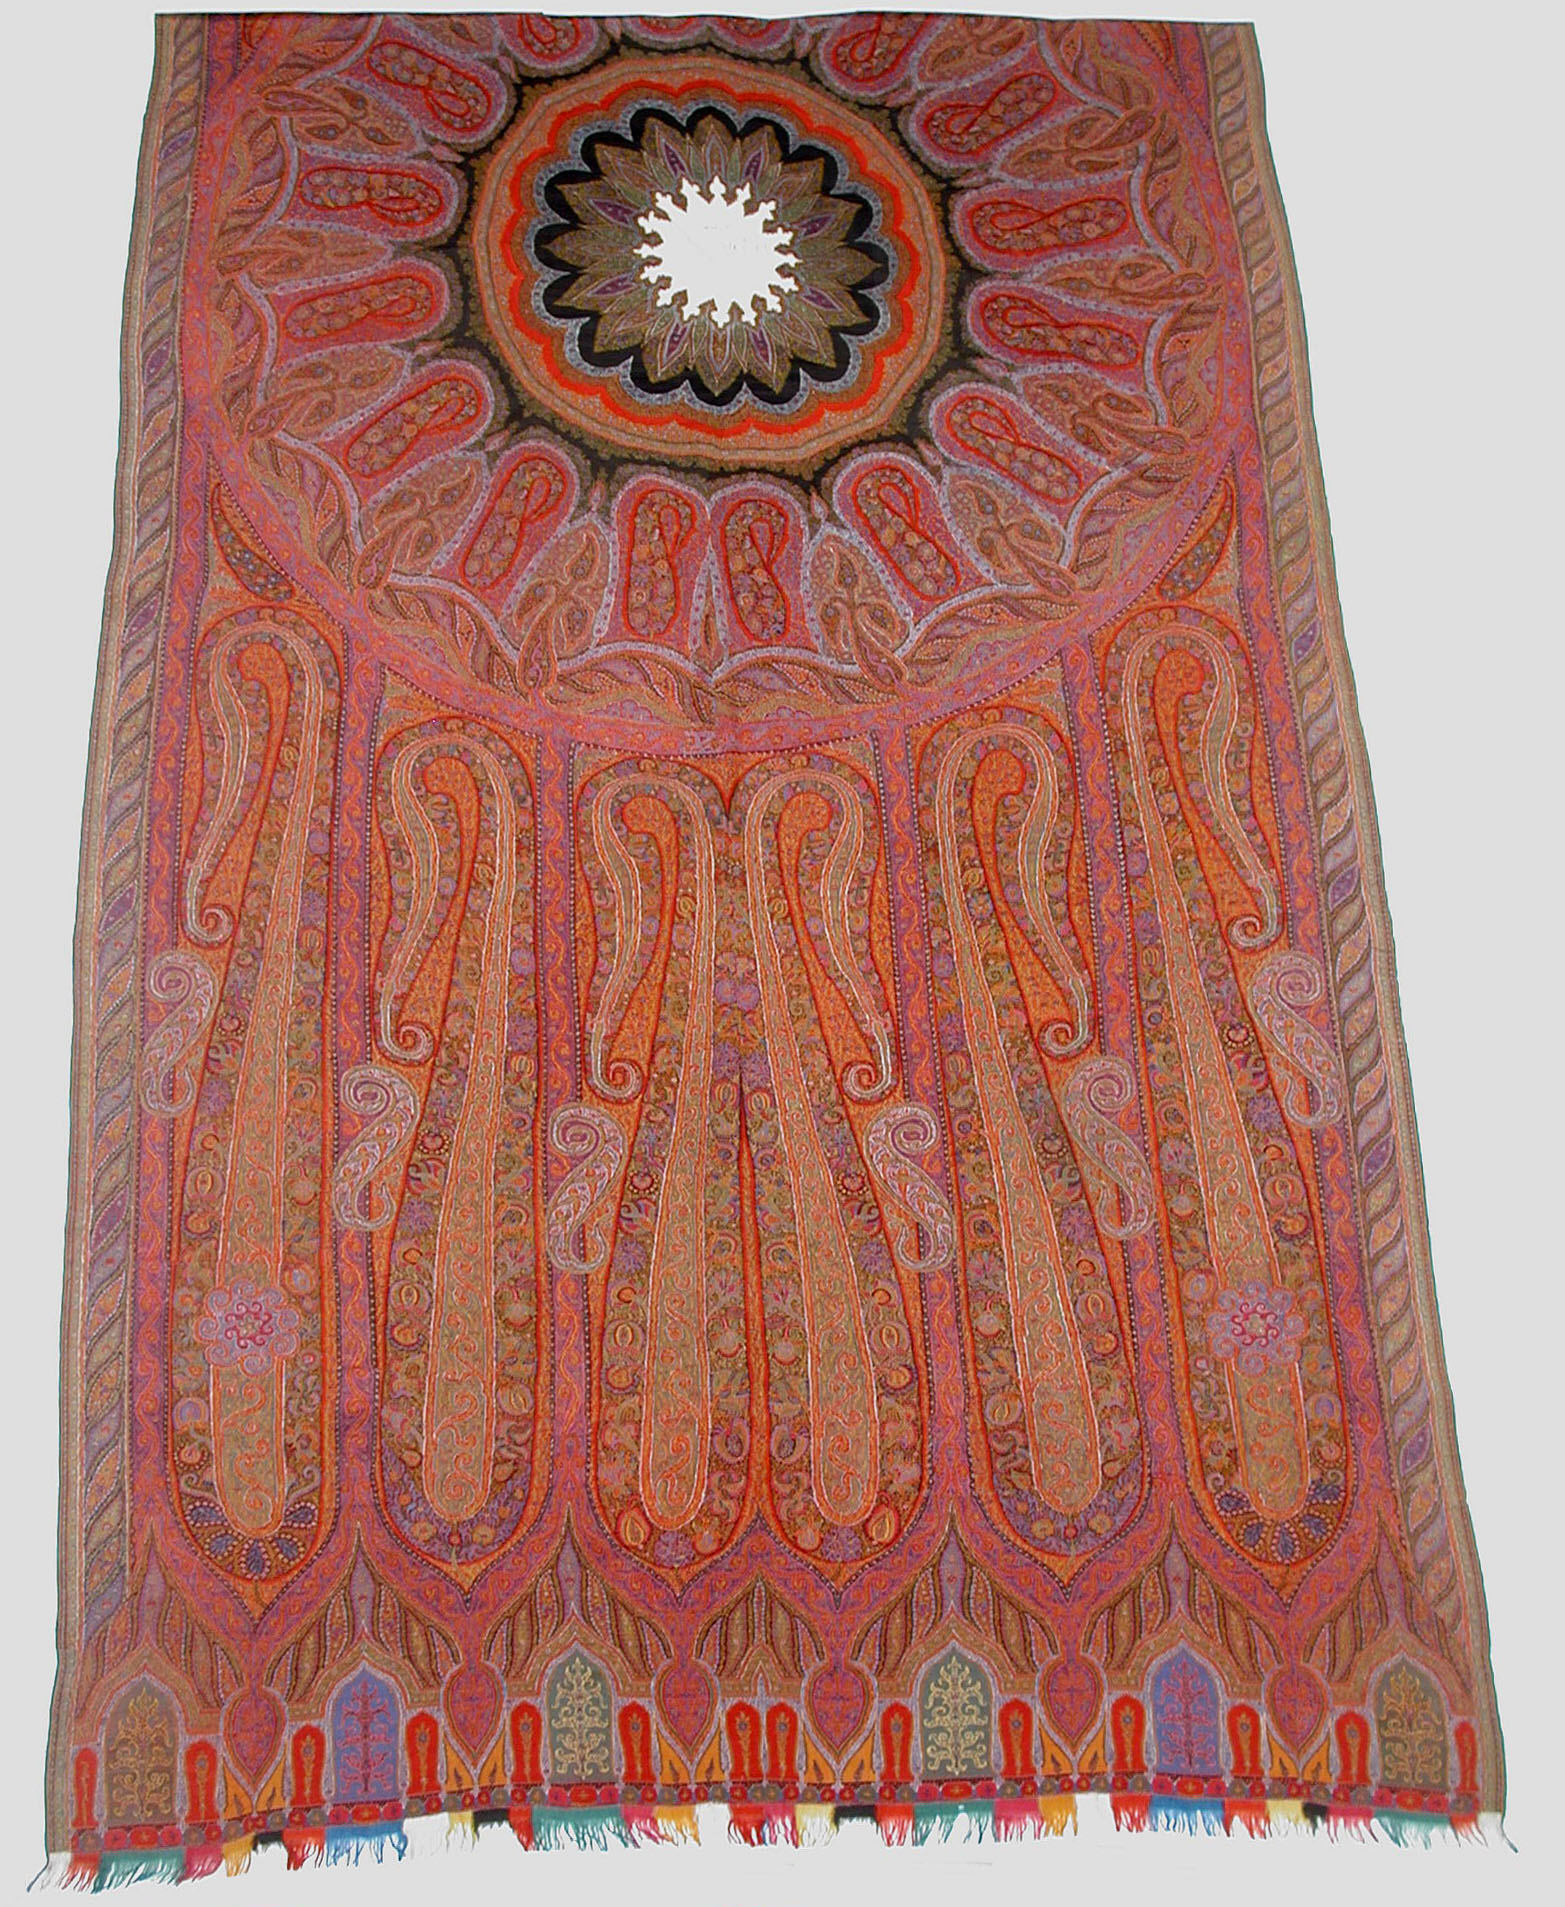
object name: shawl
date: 1834-1866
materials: wool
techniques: weave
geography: india